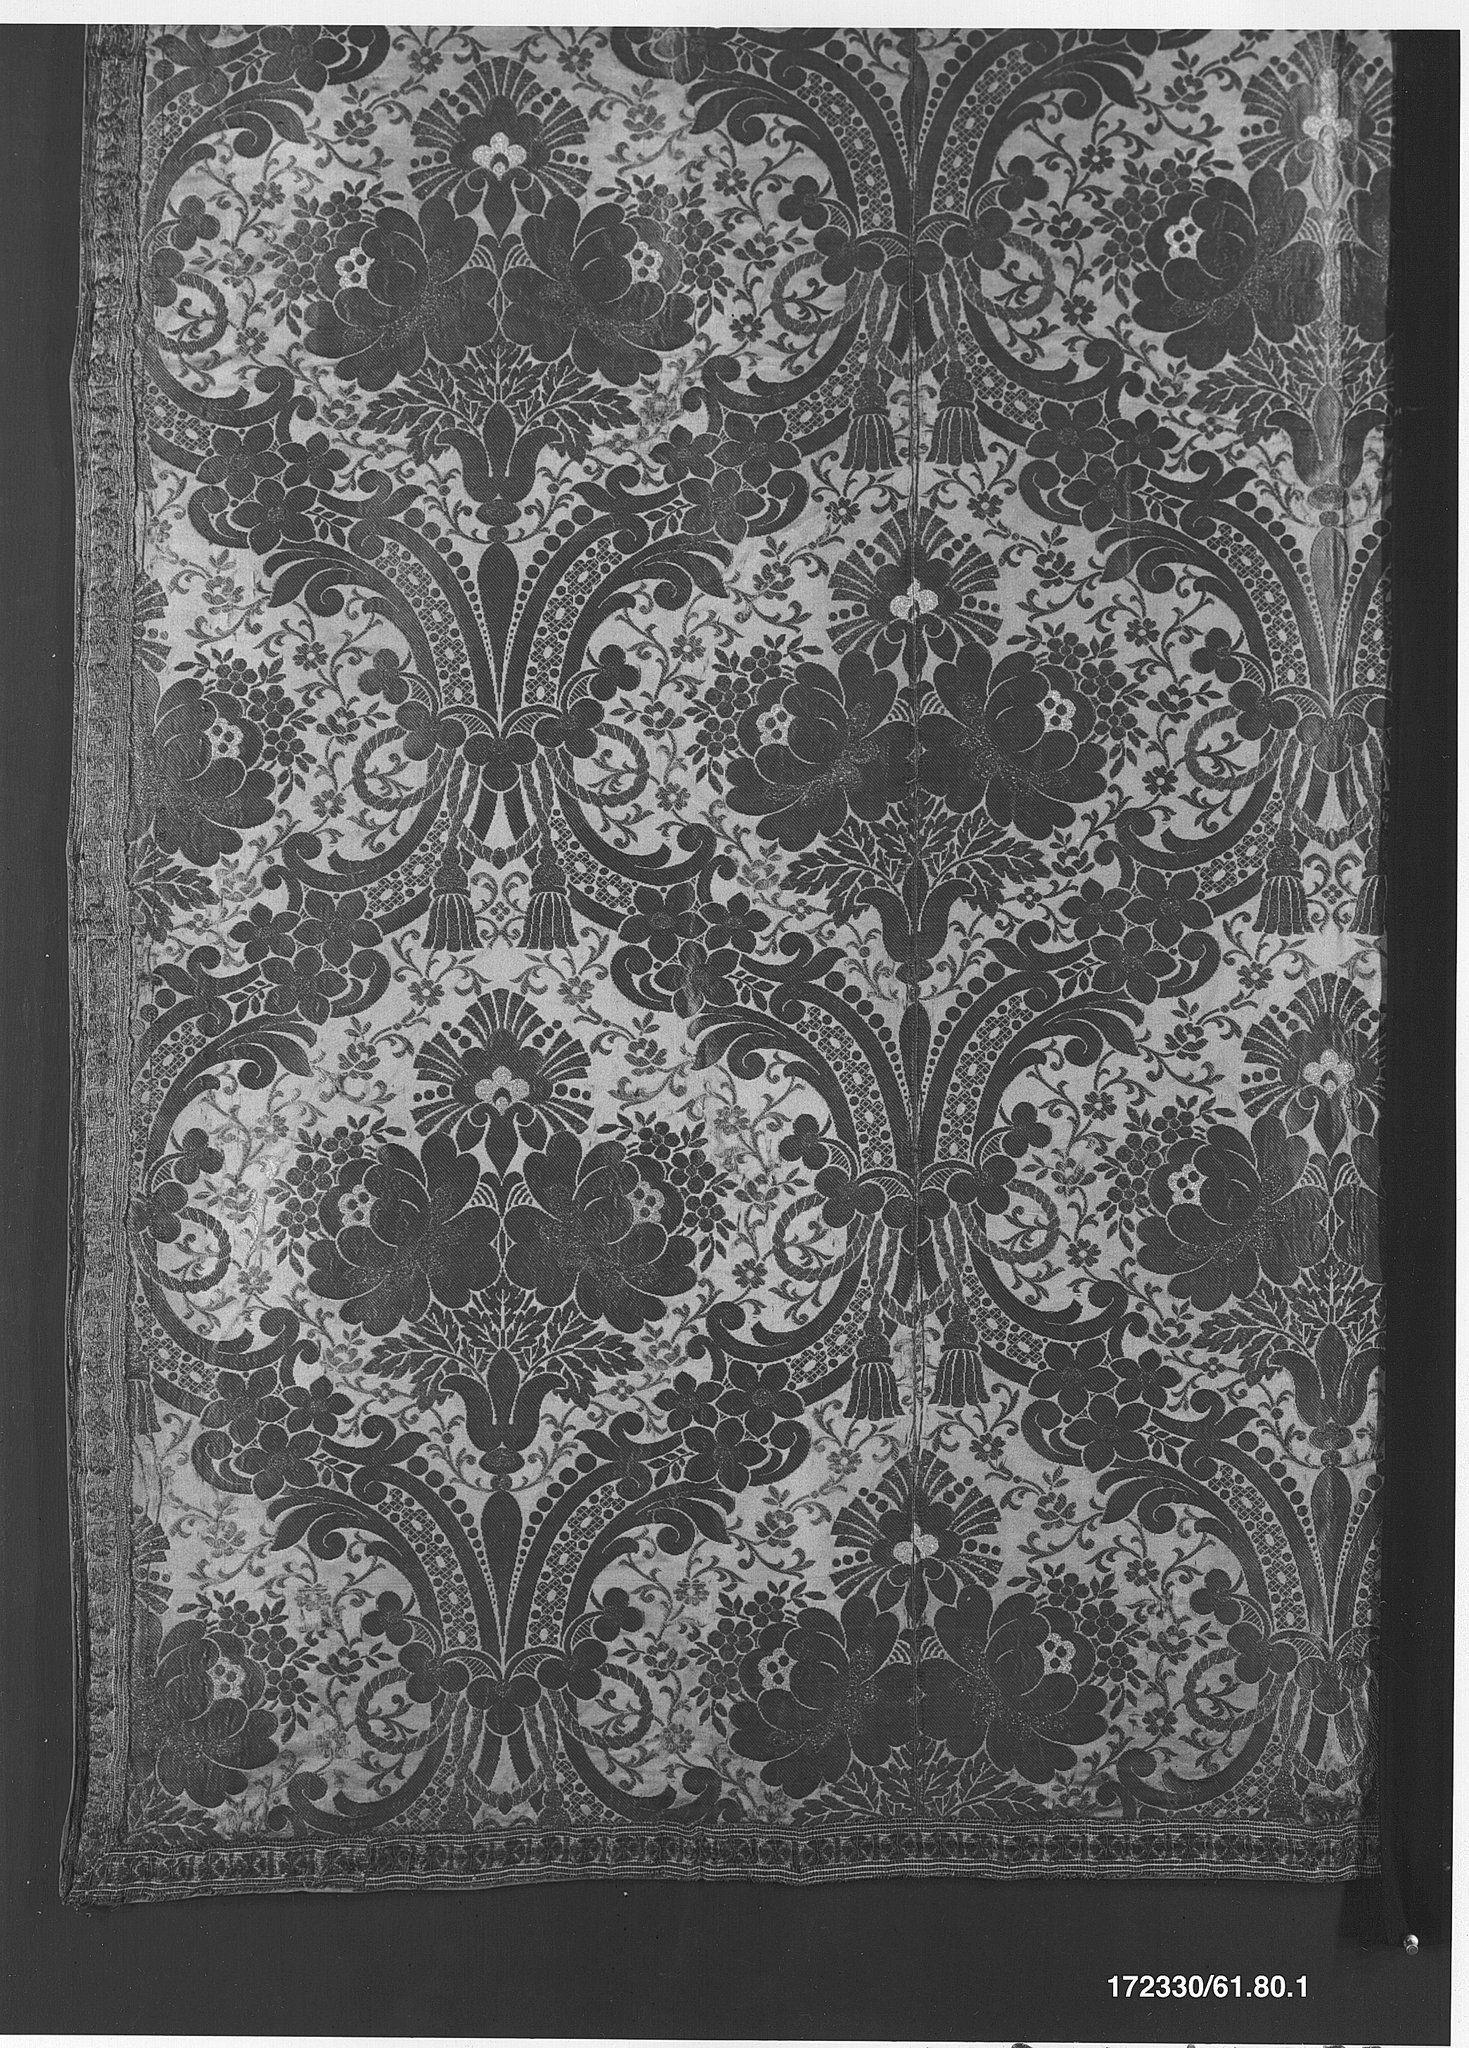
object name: piece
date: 1801-1900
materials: metal thread, silk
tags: flowers,leaves